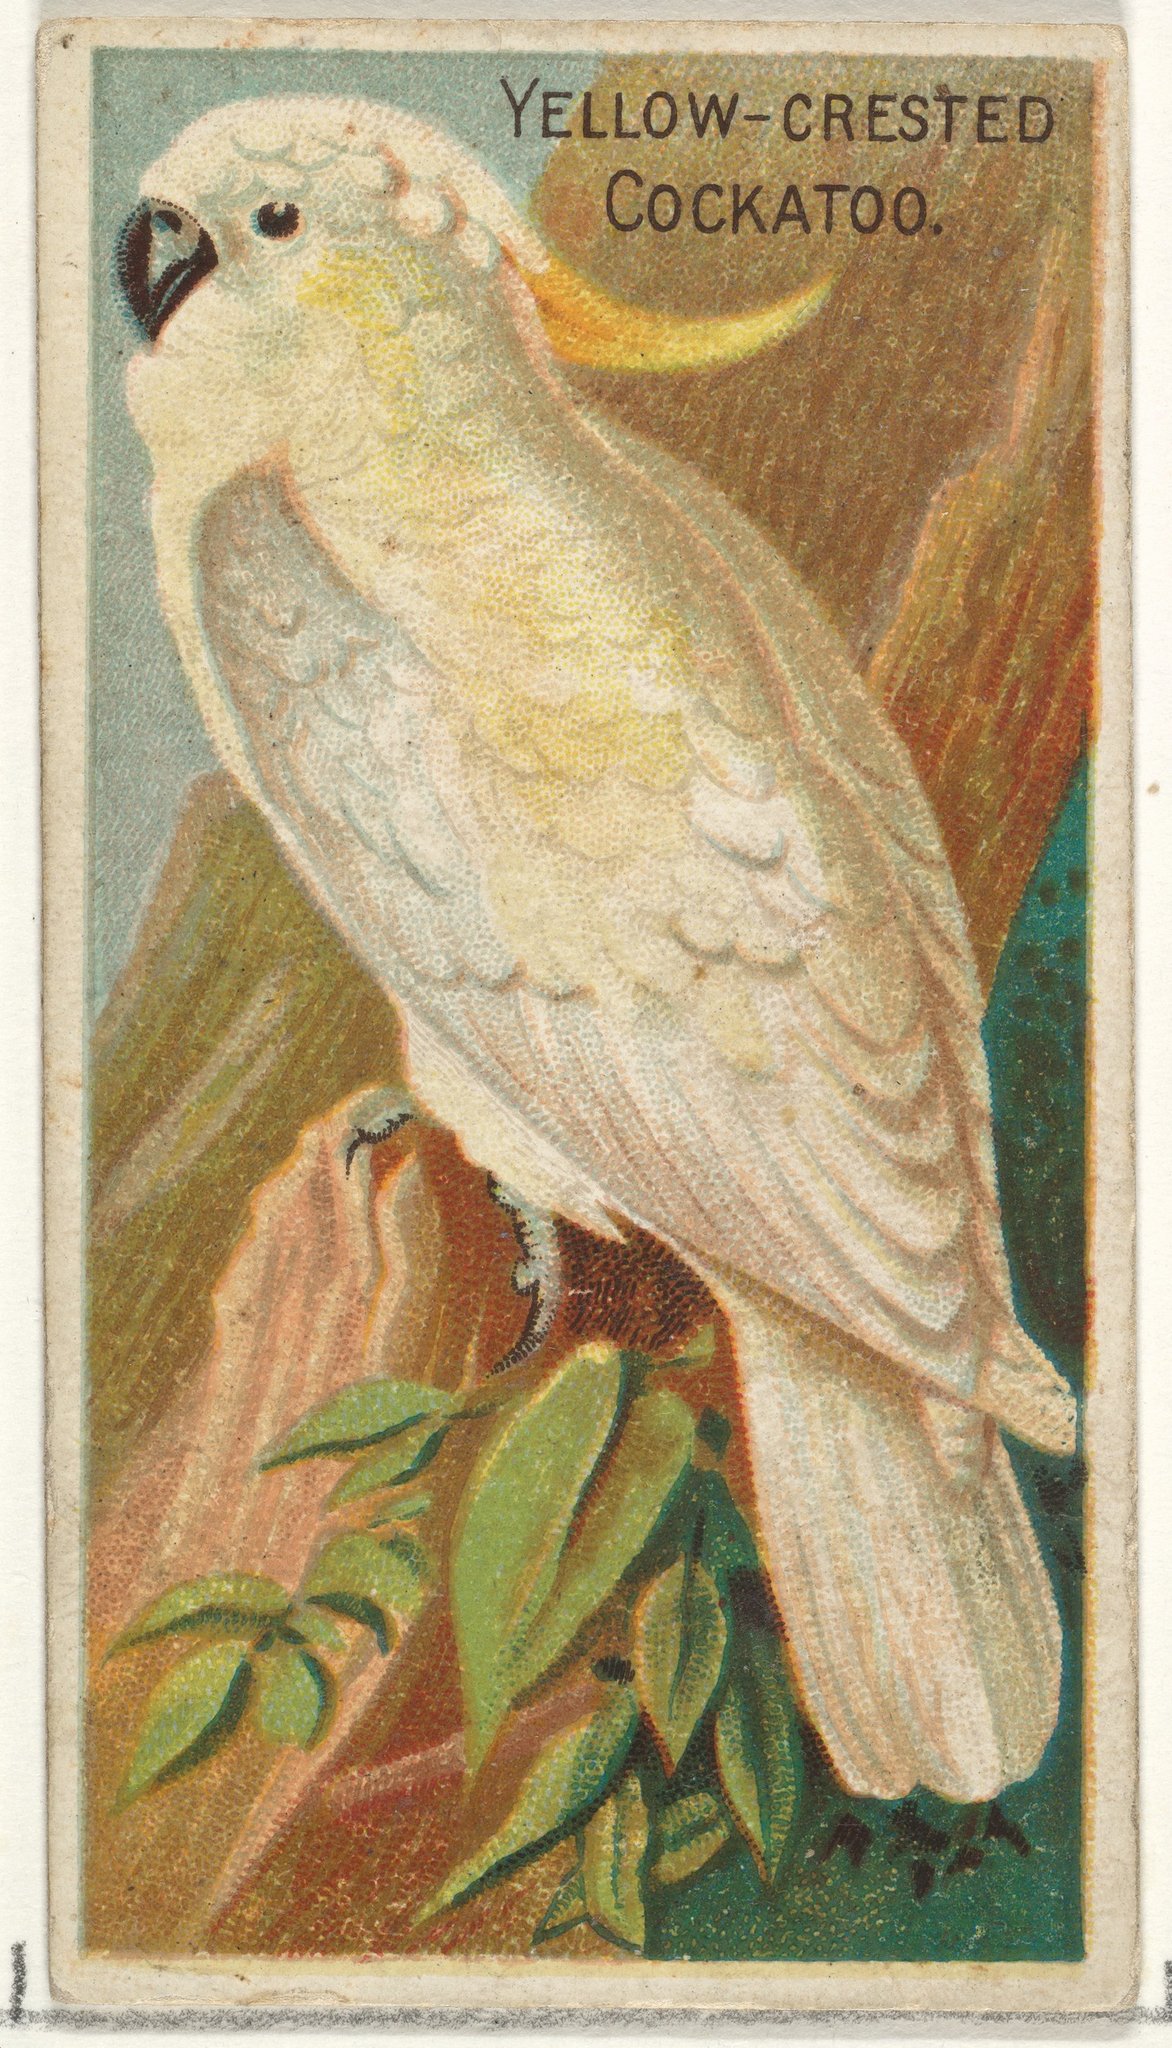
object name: print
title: Yellow-Crested Cockatoo, from the Birds of the Tropics series (N5) for Allen & Ginter Cigarettes Brands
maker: allen & ginter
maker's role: publisher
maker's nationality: american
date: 1889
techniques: color lithograph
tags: birds